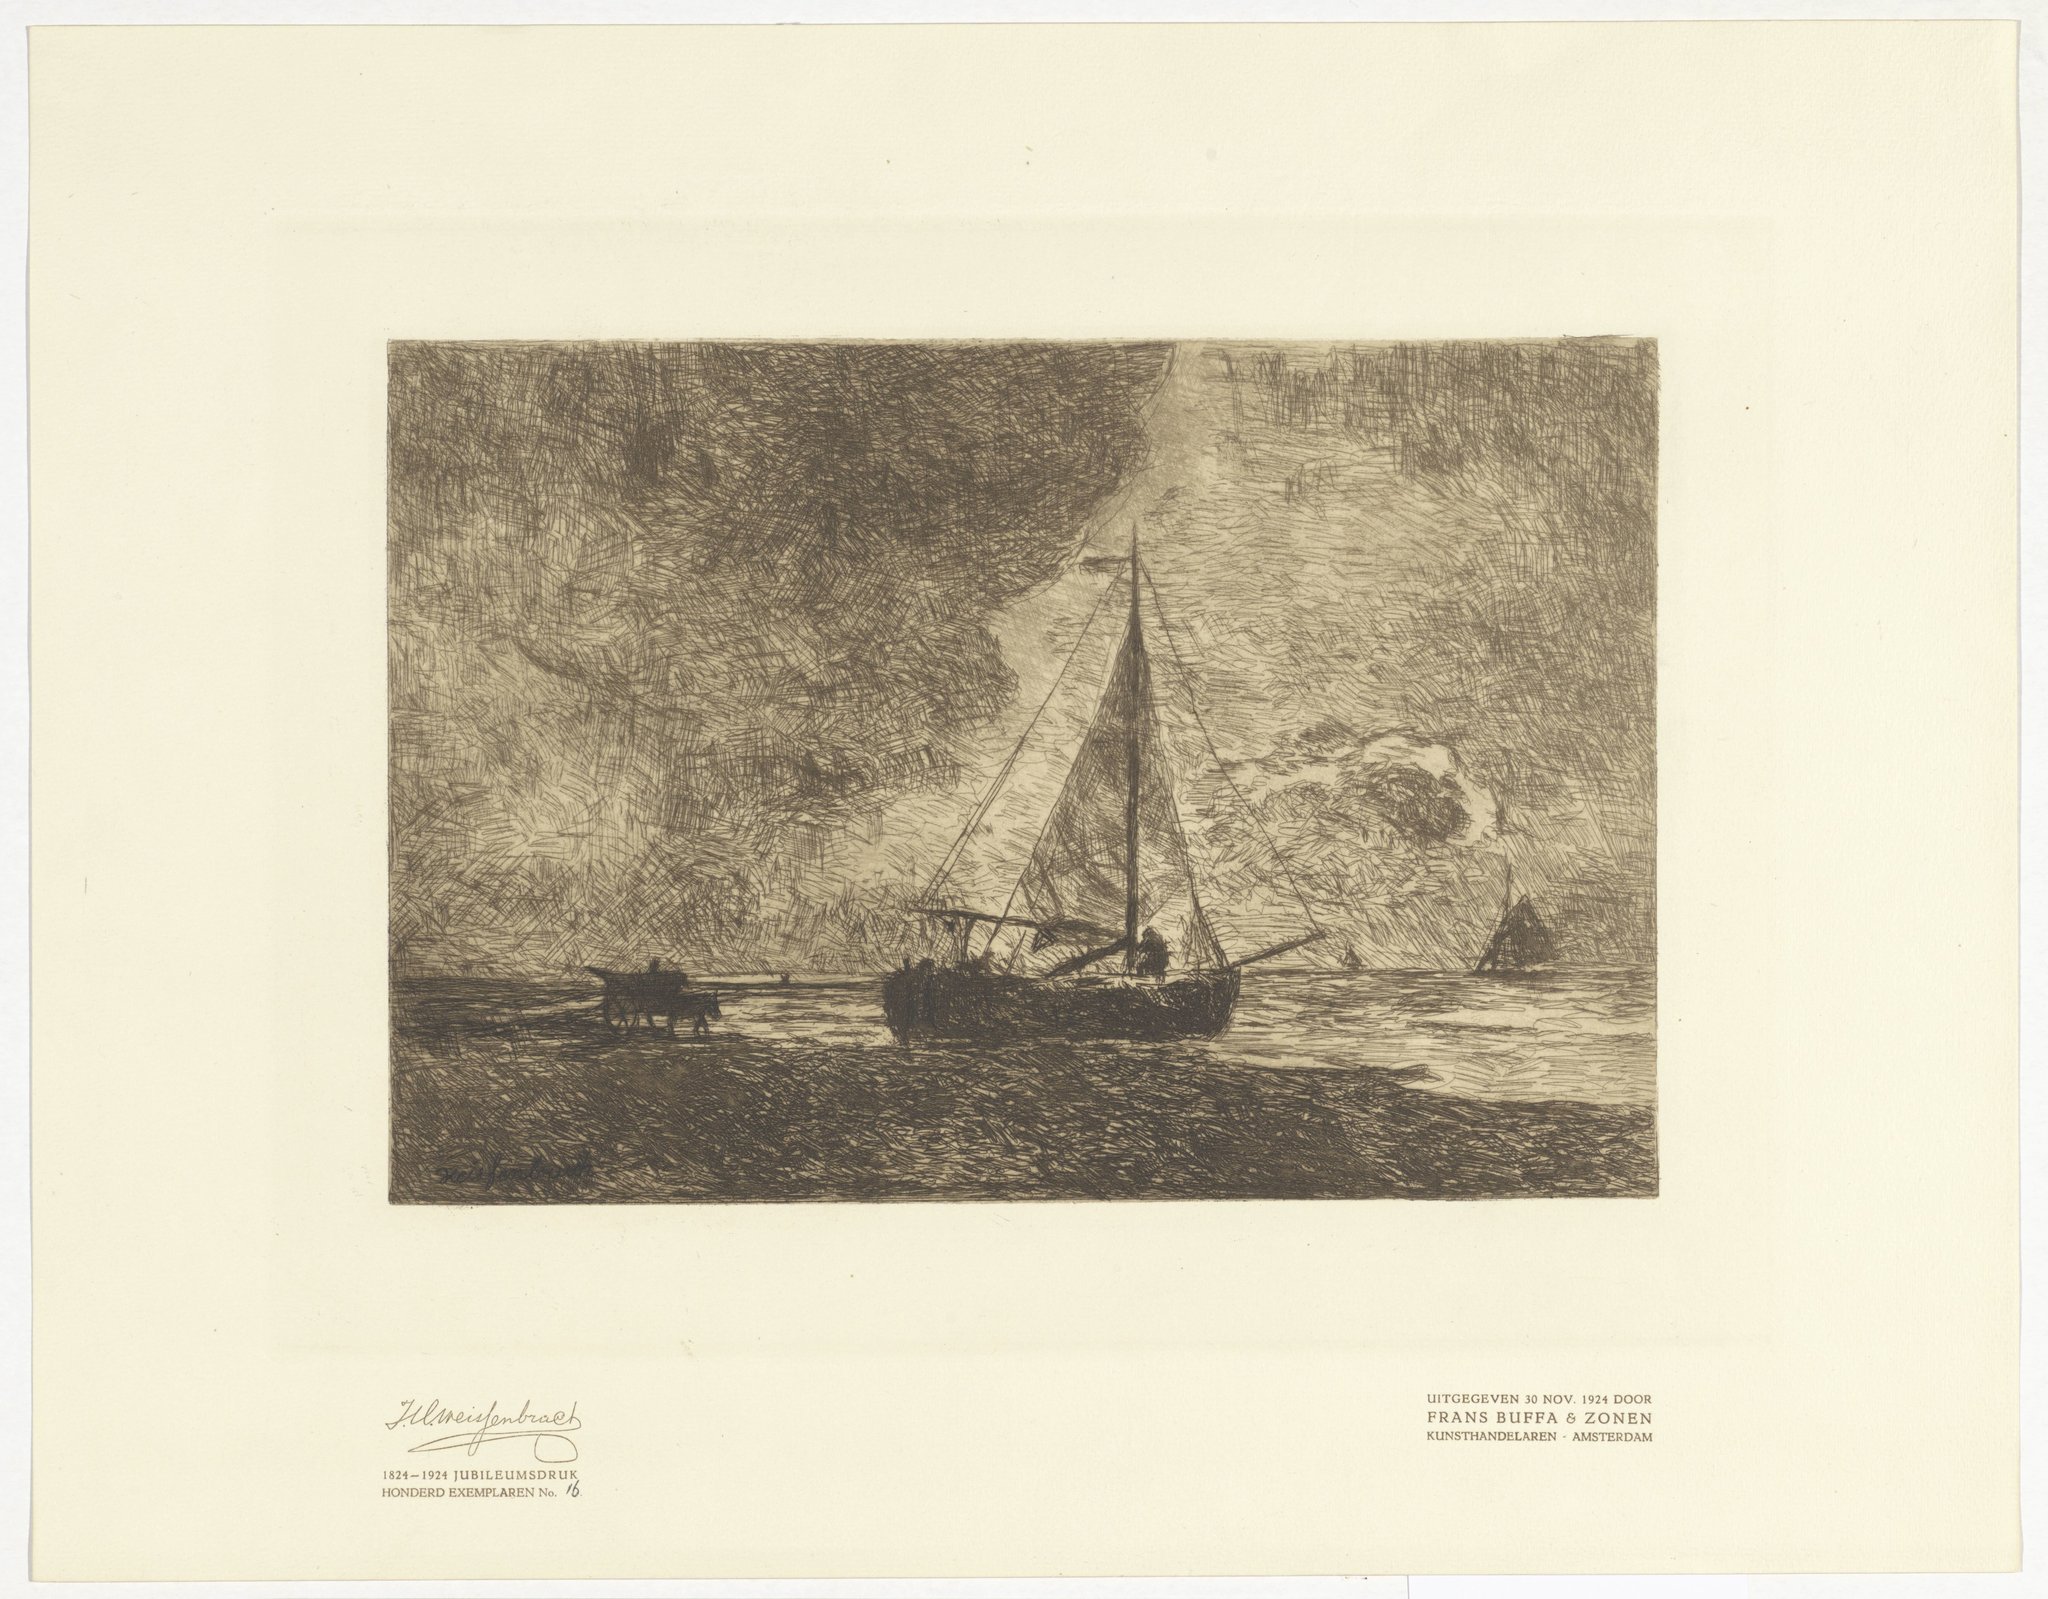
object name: print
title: Strandgezicht met zeilschepen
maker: johan hendrik weissenbruch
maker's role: draughtsman, painter, print maker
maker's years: 1824-1903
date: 1924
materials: paper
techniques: etching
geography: amsterdam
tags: sailing-ship, sailing-boat, horse, beach, (farm) wagon, freight wagon, cart, sea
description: Op het strand is een paard-en-wagen te zien. In de branding ligt een bemand zeilschip. In de verte zijn nog twee zeilschepen op zee weergegeven.